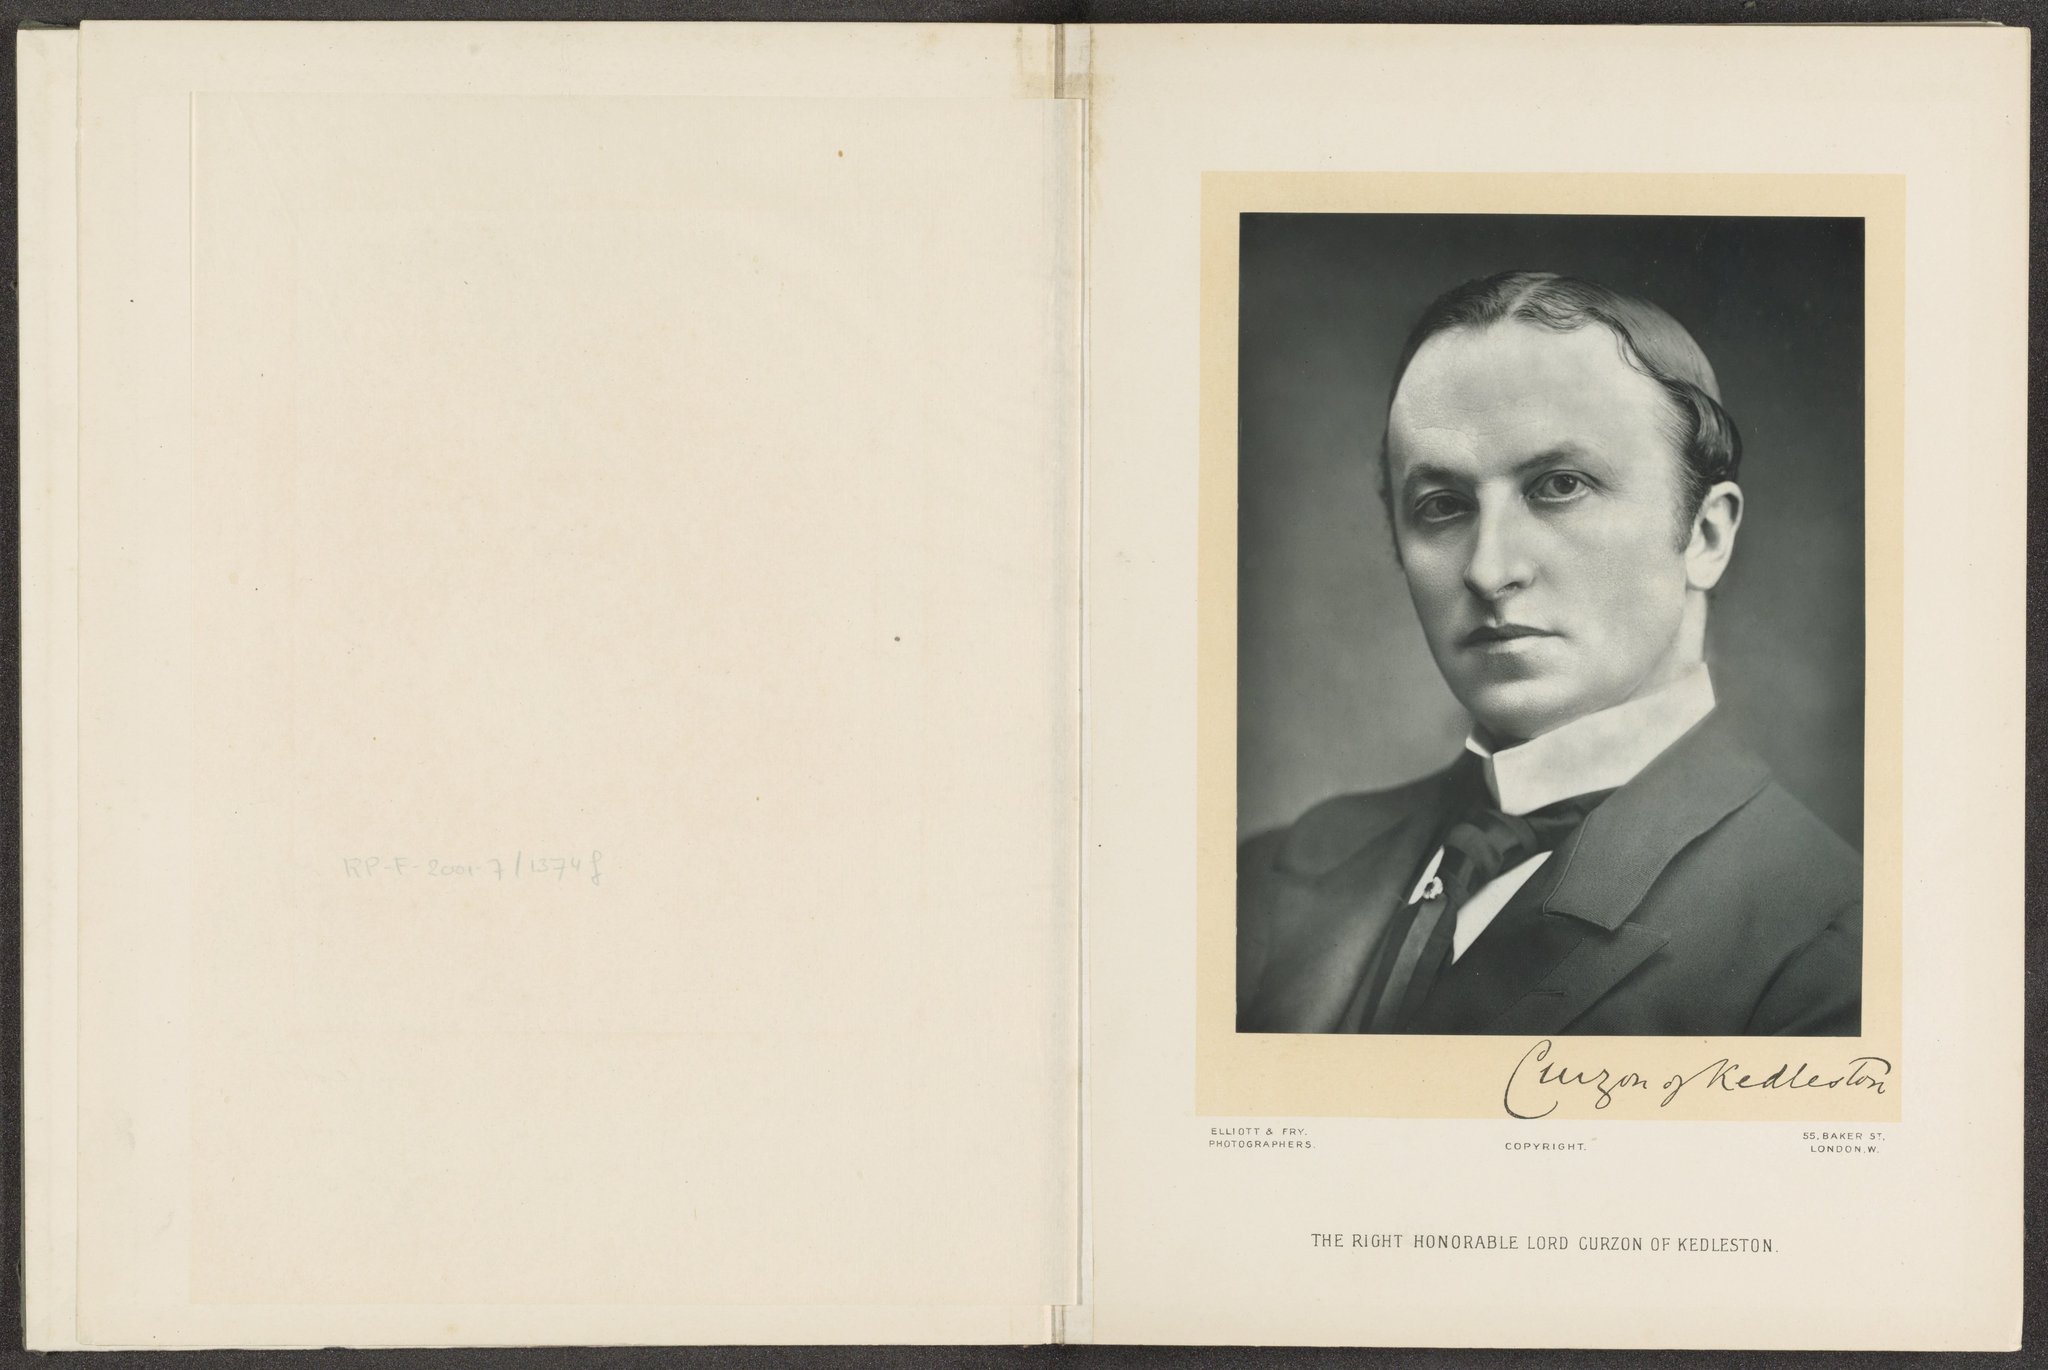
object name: photograph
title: The right honorable lord Curzon of Kedleston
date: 1893-1903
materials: paper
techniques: carbon print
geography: london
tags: politician, historical persons (portraits and scenes from the life) (+ (full) bust portrait)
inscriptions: inscription: ‘55, Baker St, London, W.’, annotation